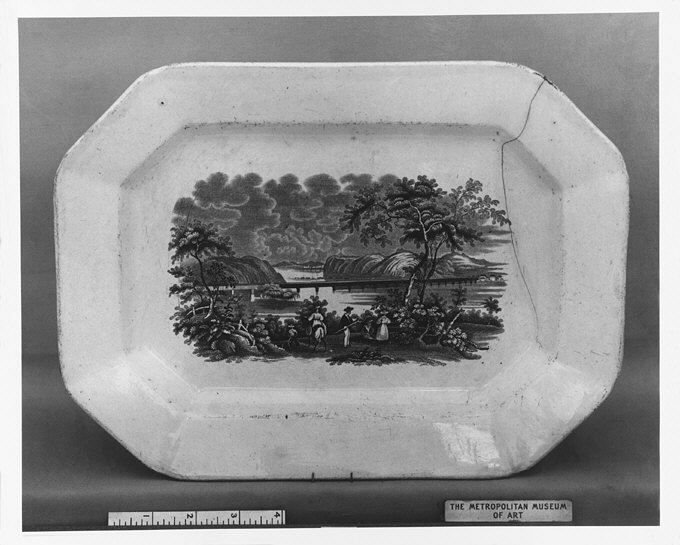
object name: platter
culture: british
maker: william ridgway & co.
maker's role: maker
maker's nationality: british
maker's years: 1834-1854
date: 1840-1854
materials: earthenware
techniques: transfer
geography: england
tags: landscapes